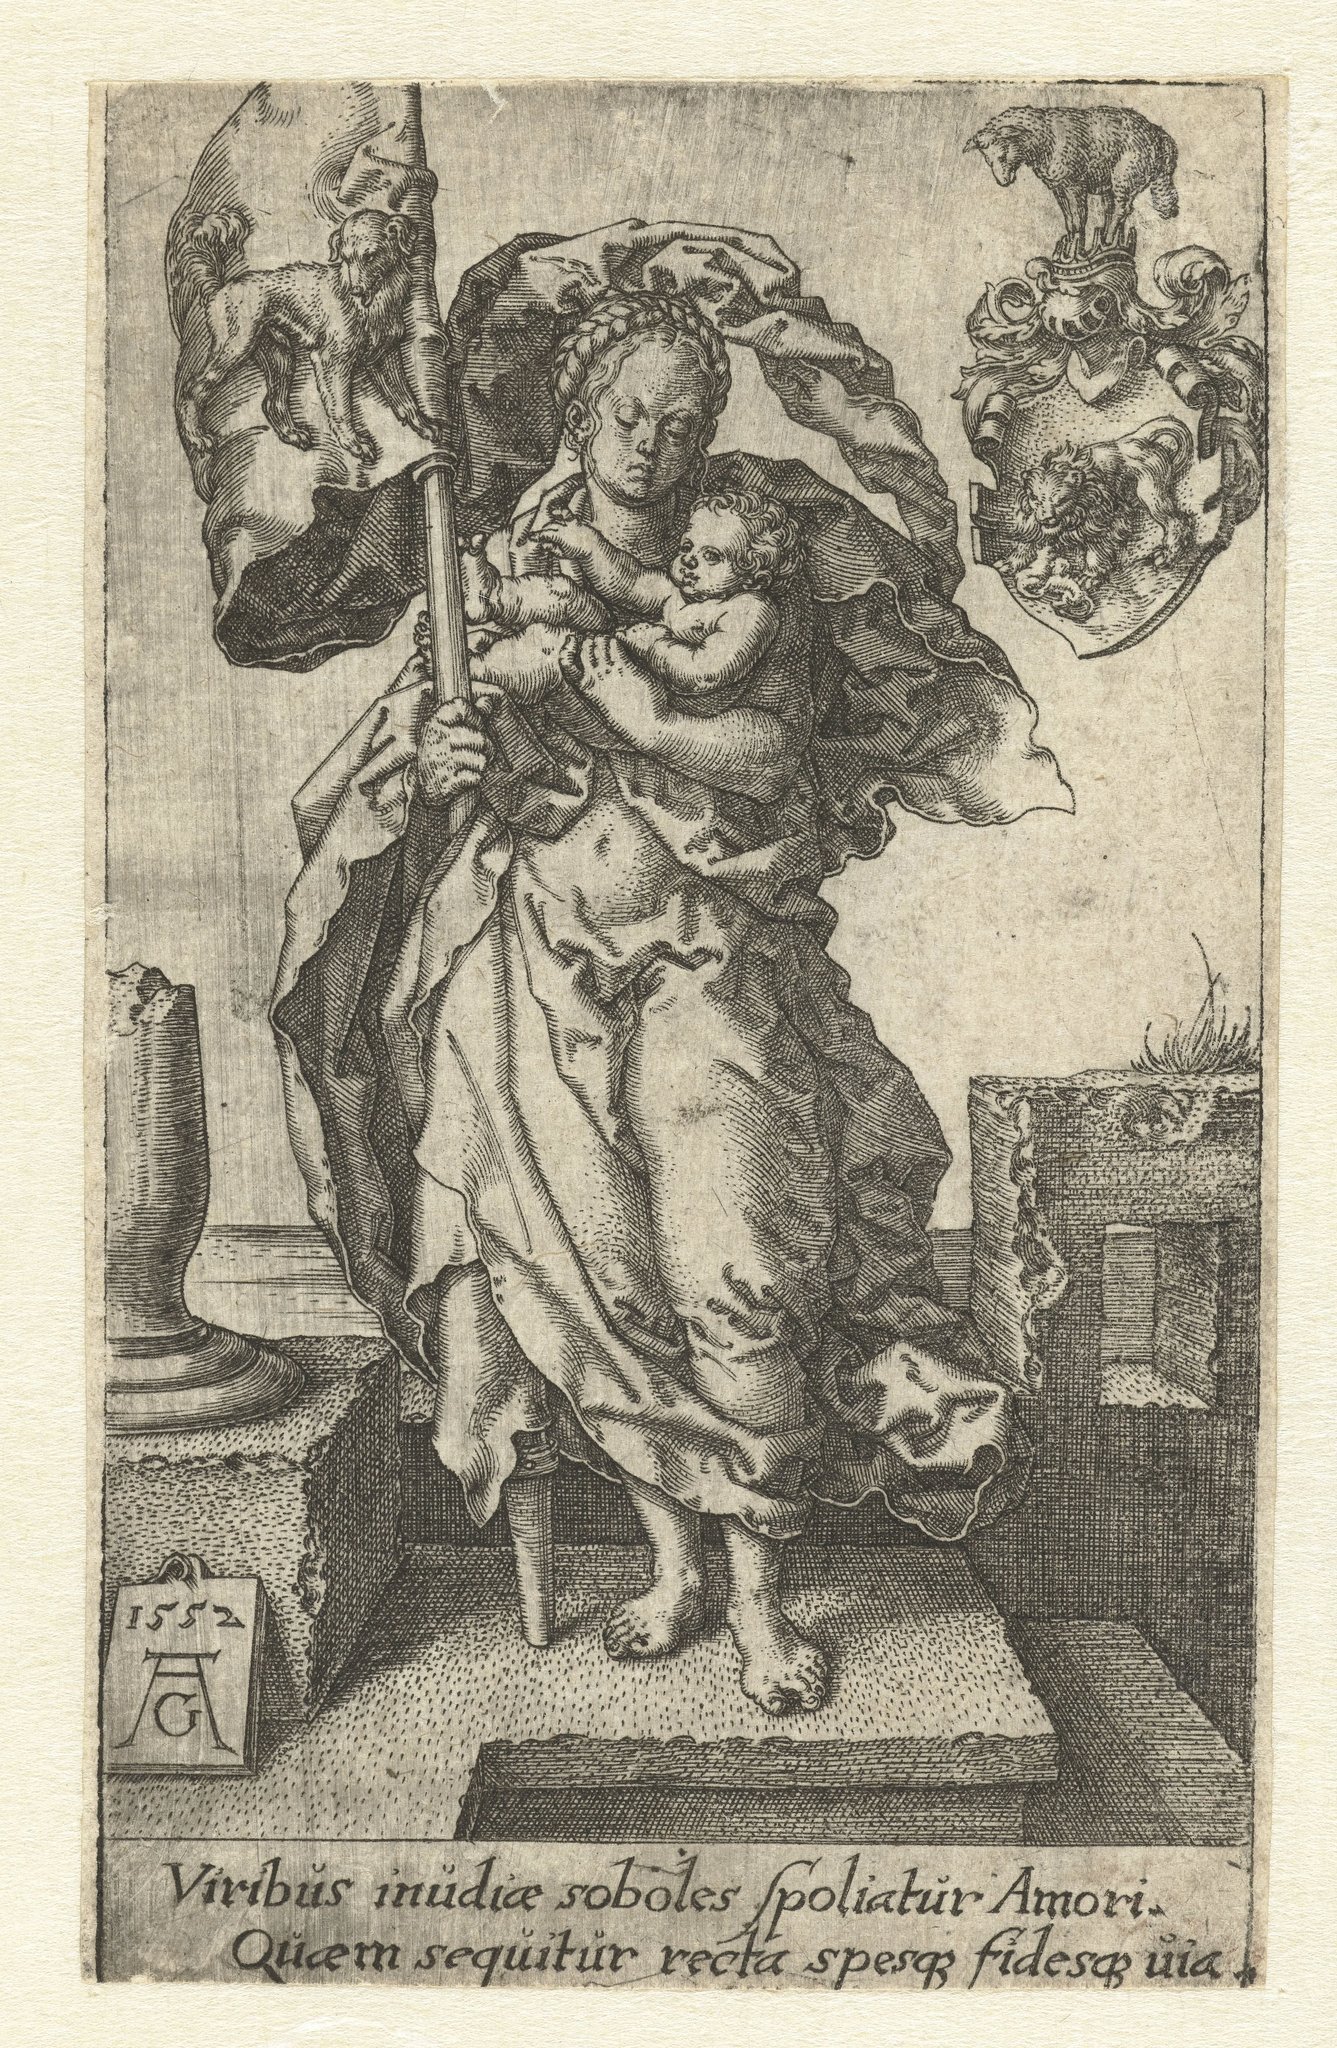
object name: print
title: Naastenliefde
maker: heinrich aldegrever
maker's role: draughtsman, print maker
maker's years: 1502-1561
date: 1552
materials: paper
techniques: engraving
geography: germany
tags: charity, 'caritas'; 'carità' (ripa) ~ one of the three theological virtues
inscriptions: collector's mark: Lugt 11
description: Personificatie van de naastenliefde. Vrouw met kind op haar linkerarm, in haar rechterhand een vaandel met daarom een afbeelding van een hond. Rechtboven een wapenschild met de leeuwin die haar dode jongen lucht in blaast, bovenop een lam. Onder de voorstelling een tweeregelige tekst in het Latijn. Zesde prent uit een serie van zeven.